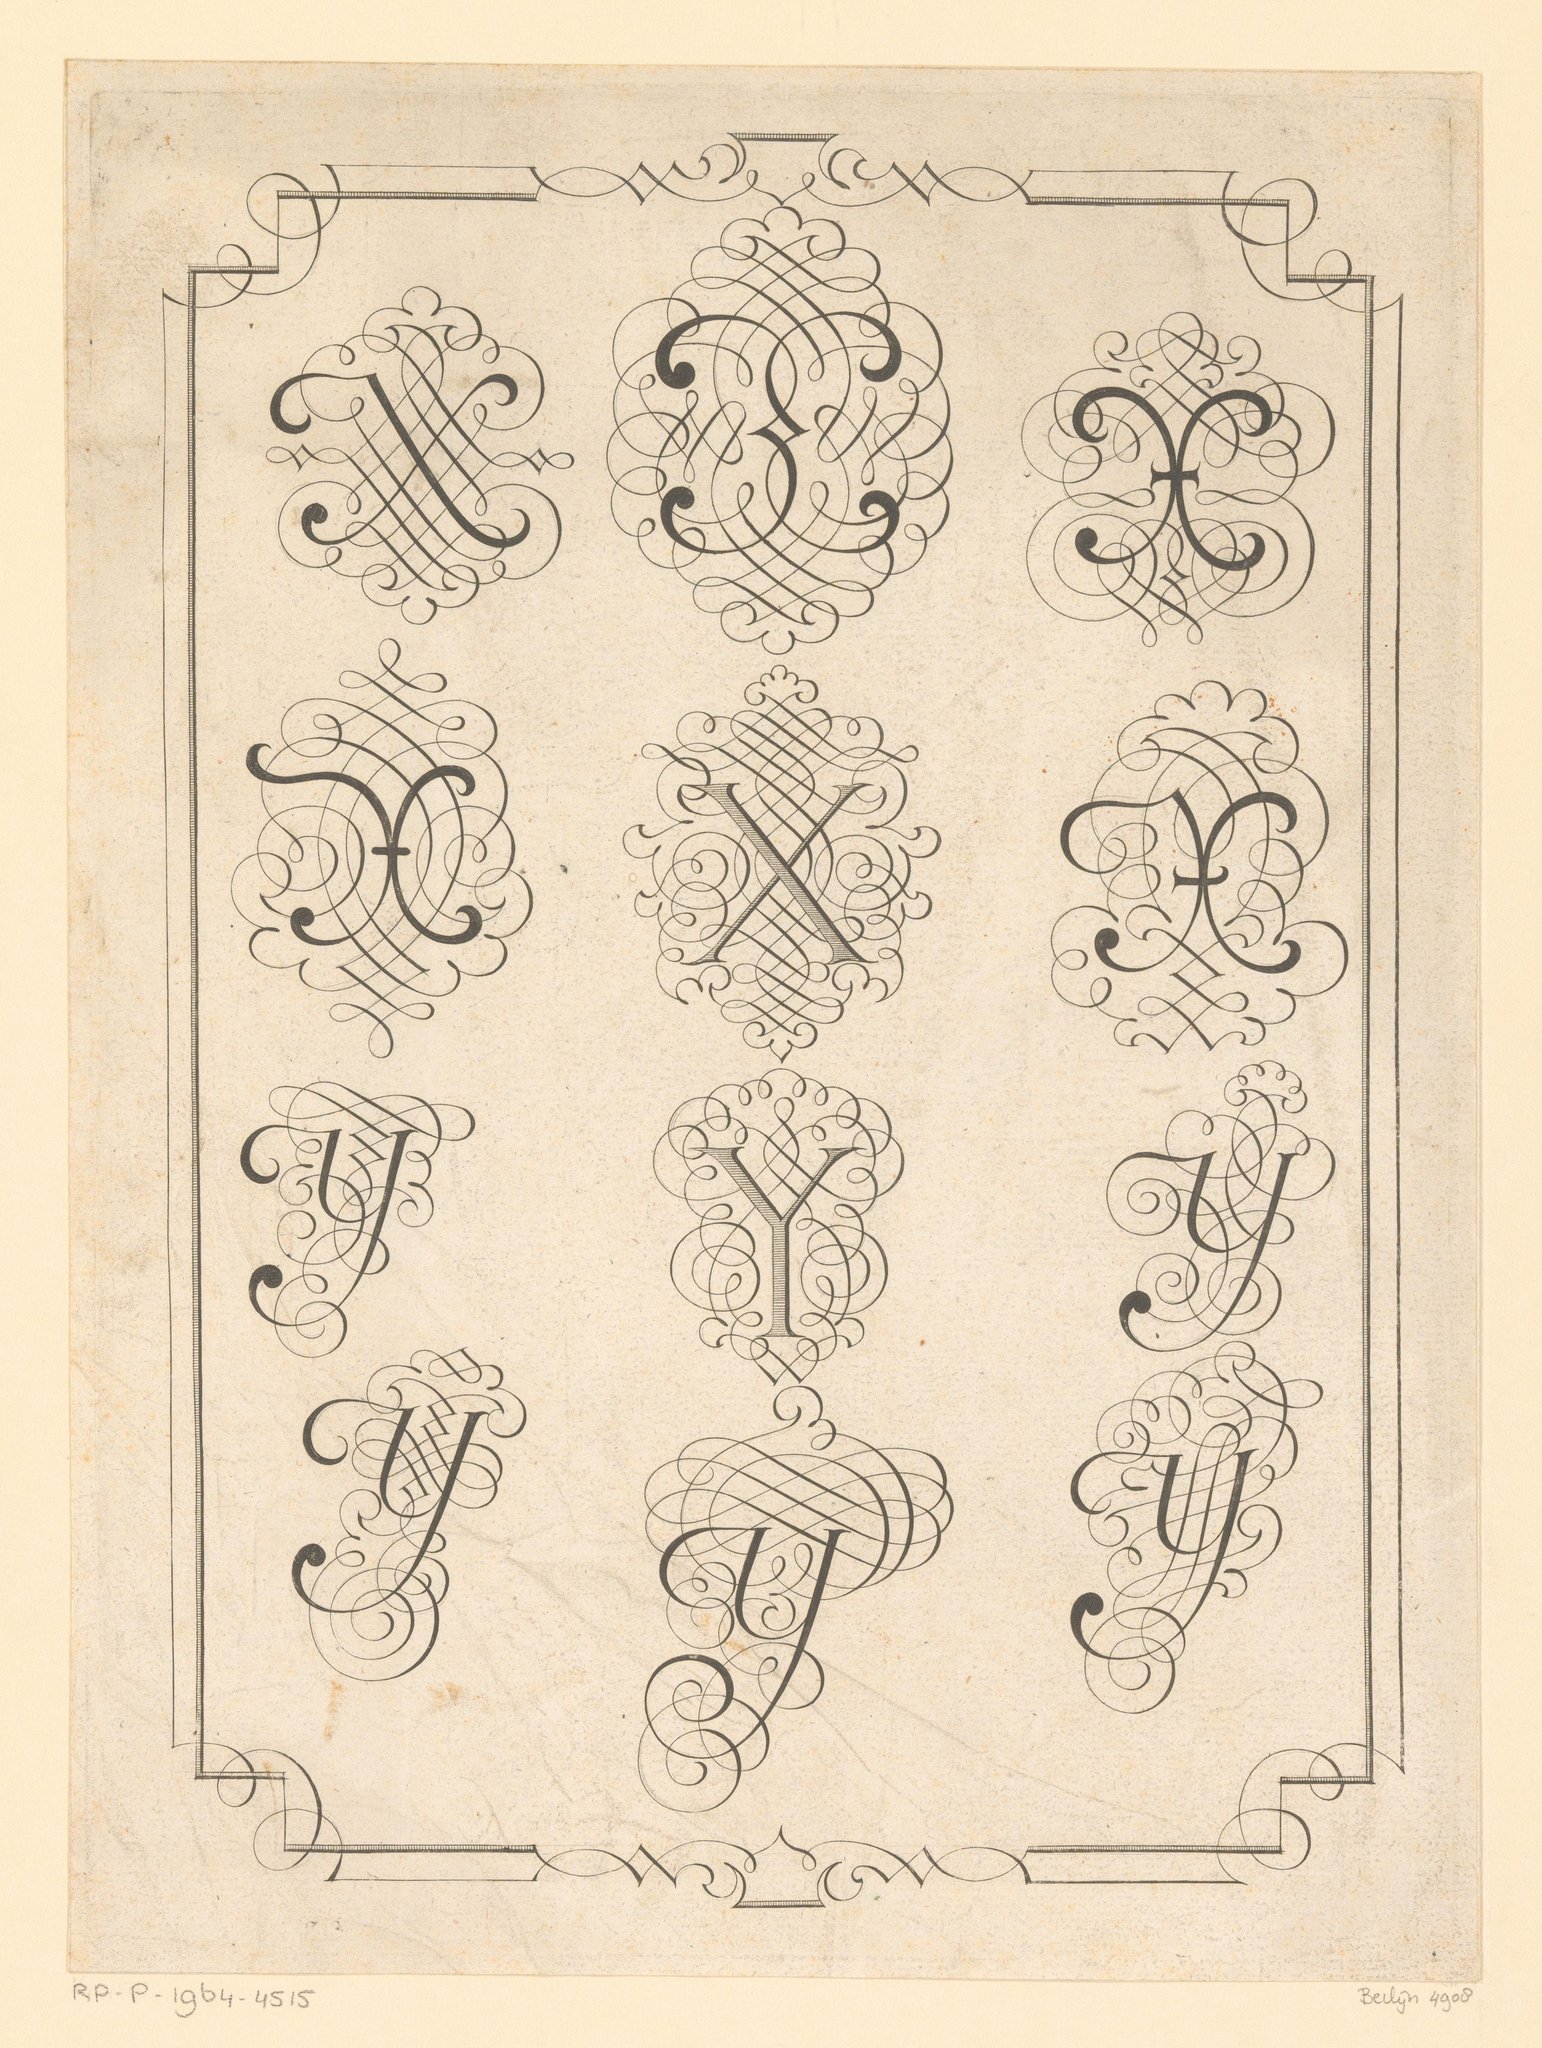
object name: ornament print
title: Letters X en Y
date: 1756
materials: paper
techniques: engraving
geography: vienna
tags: letters, alphabet, script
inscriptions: collector's mark: Lugt 2228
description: Zesmaal gekalligrafeerde letters X en Y.